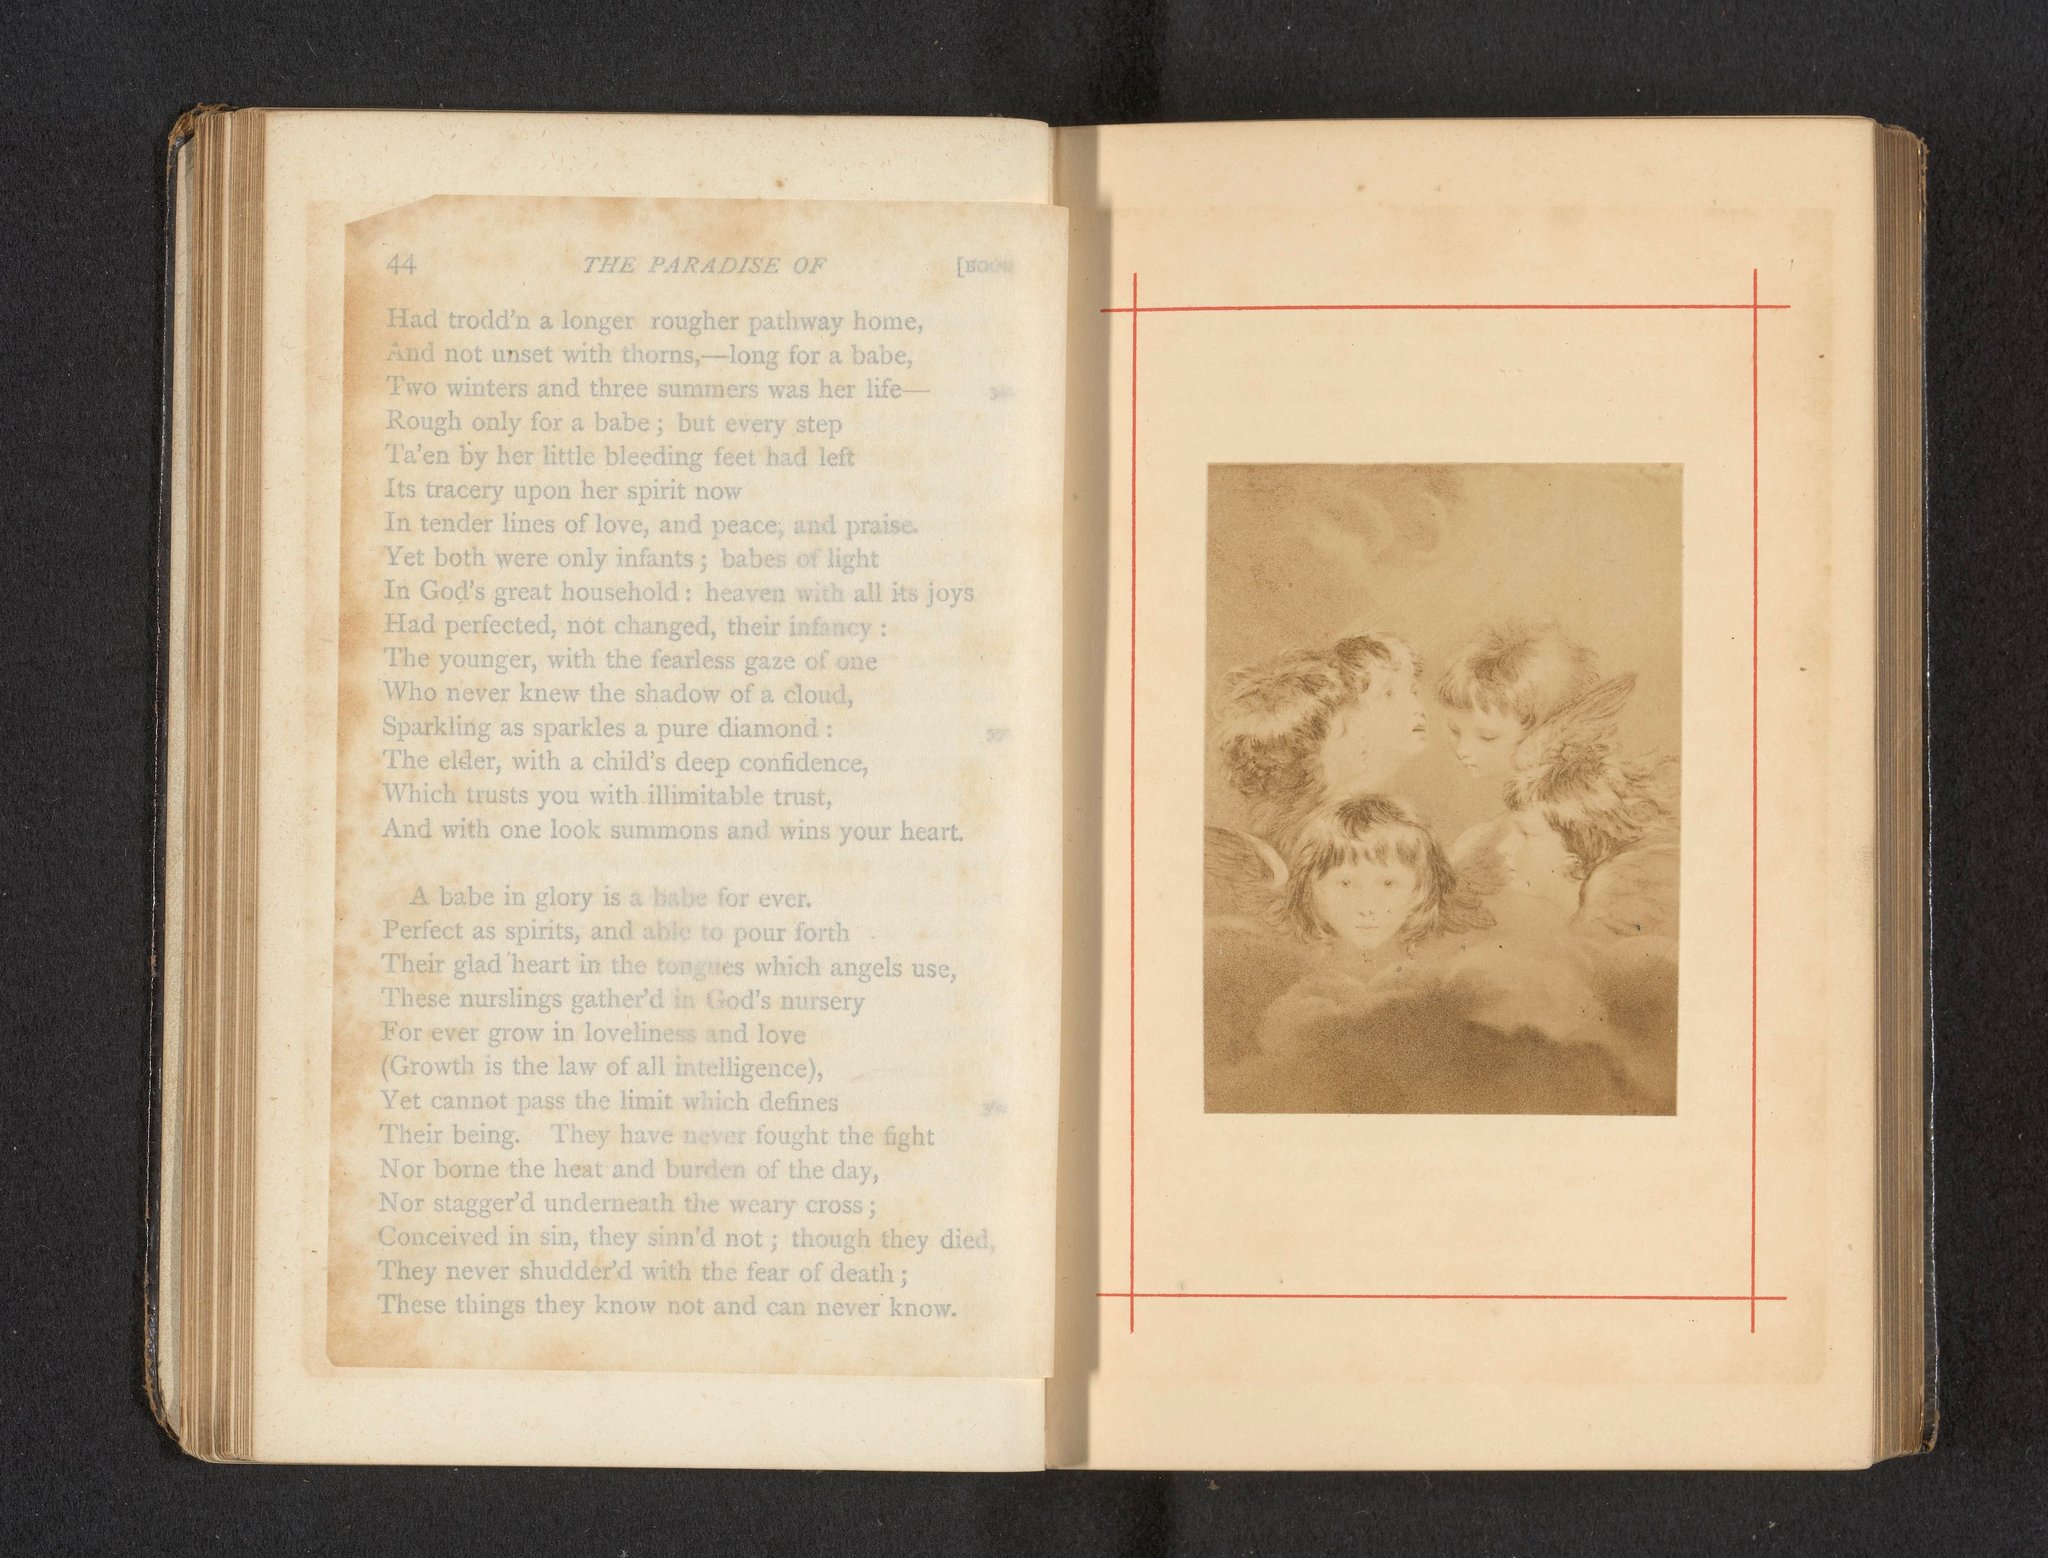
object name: page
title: Fotoreproductie van een schilderij, voorstellende vijf cherubijnen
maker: Anonymous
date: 1868-1878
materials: photographic support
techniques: albumen print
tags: cherubs, i.e. children's heads with wings